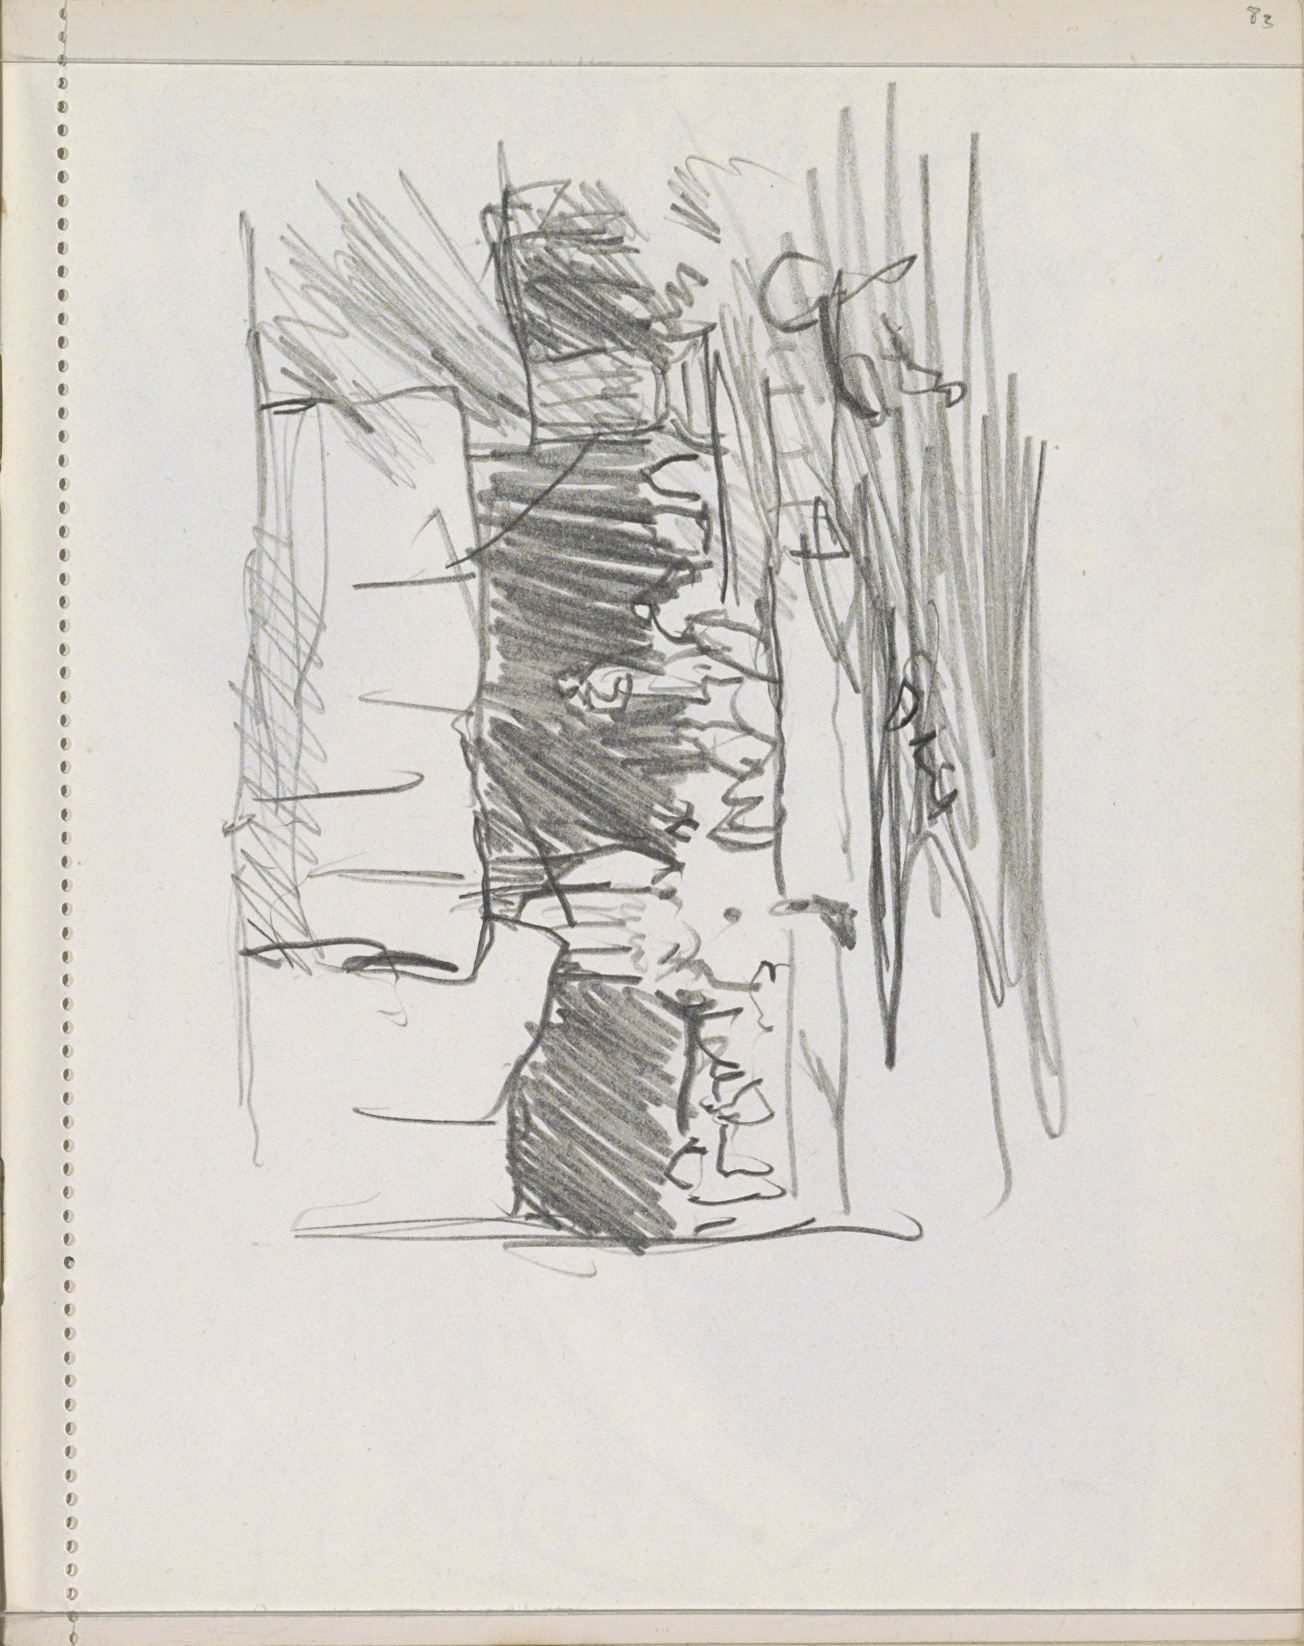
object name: sketchbook leaf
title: Figuren bij twee zuilen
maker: marius bauer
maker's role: draughtsman, print maker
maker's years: 1867-1932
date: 1924-1925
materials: paper, pencil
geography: india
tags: standing figure, sitting figure, column, pillar ~ architecture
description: Eén figuur staat en verschillende figuren zitten op een verhoging waarop twee zuilen, mogelijk van een tempel, staan. Pagina 83 uit een schetsboek met 75 bladen.